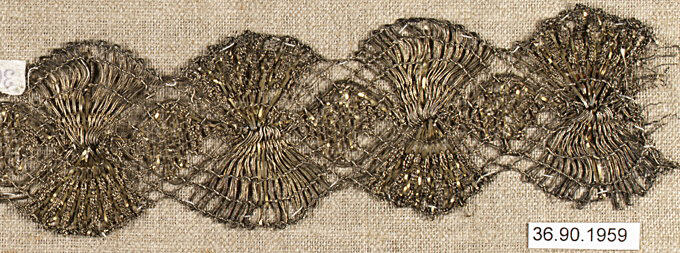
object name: piece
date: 1801-1900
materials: metal thread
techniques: lace